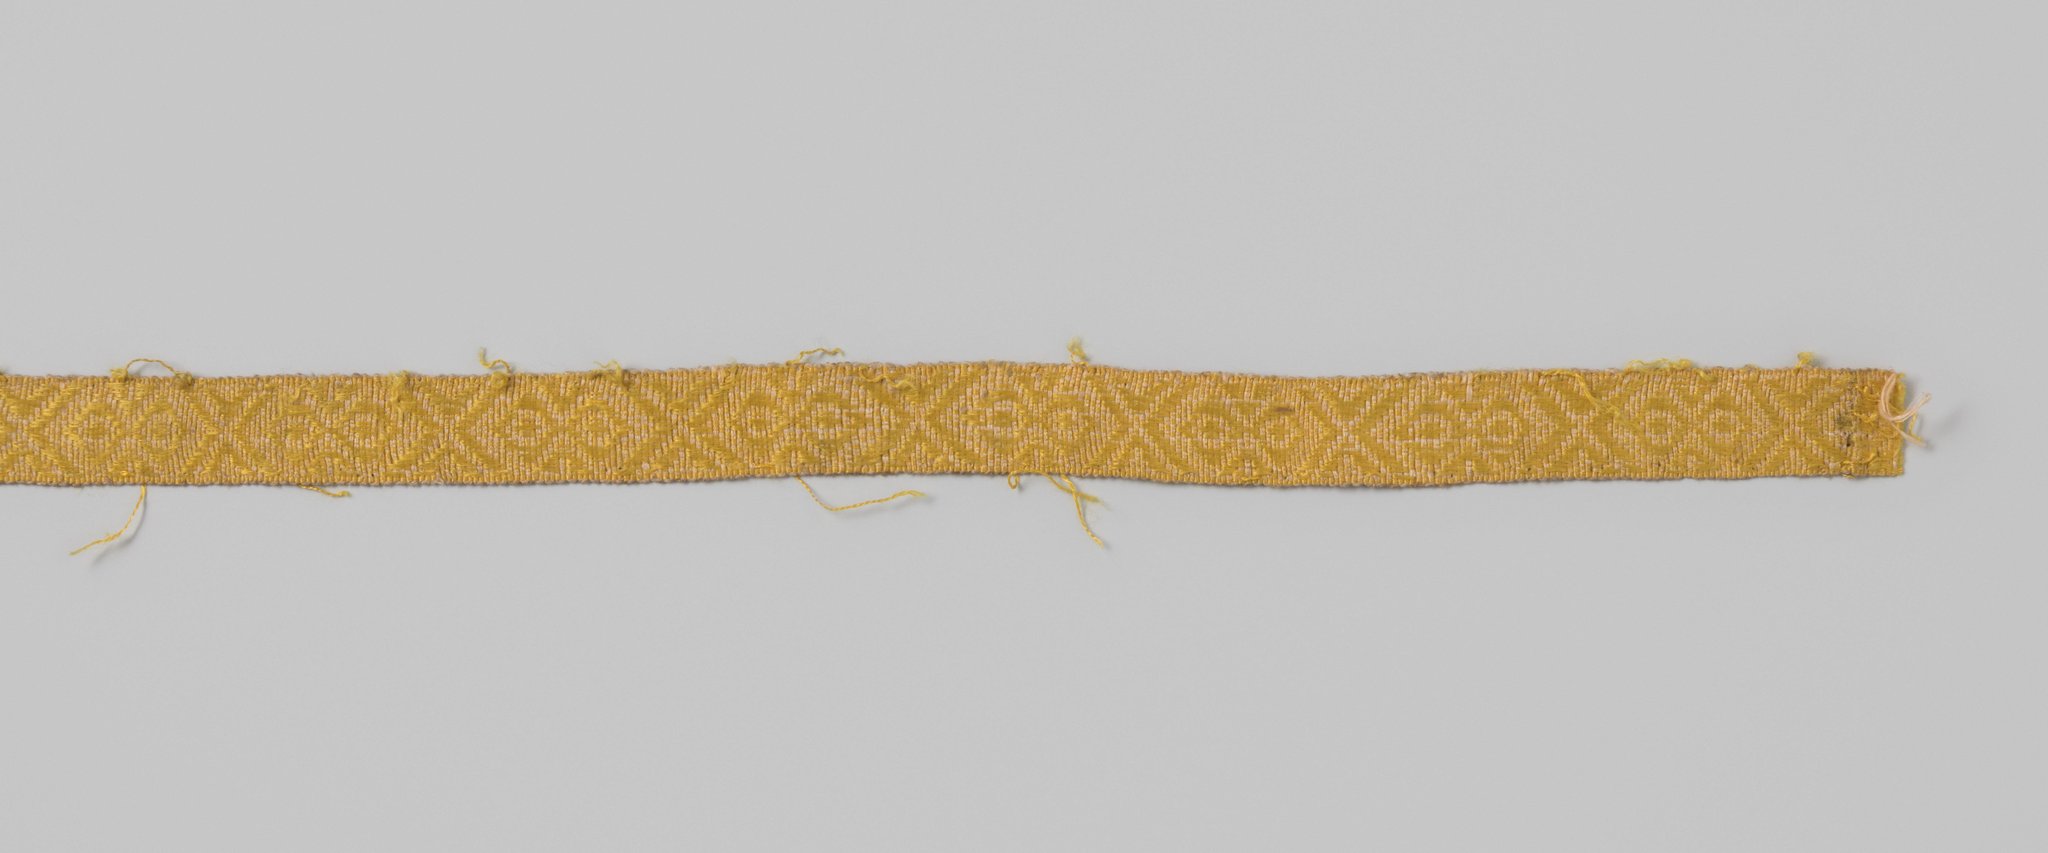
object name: braid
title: Passement van linnen en gele zijde in ruitpatroon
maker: Anonymous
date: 1700-1899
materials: linen, silk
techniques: weave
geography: europe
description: Passement van linnen en gele zijde in een patroon van ruiten in ruiten. BK-NM-12186-19, BK-NM-12186-20-A en BK-NM-12186 hebben eenzelfde patroon.